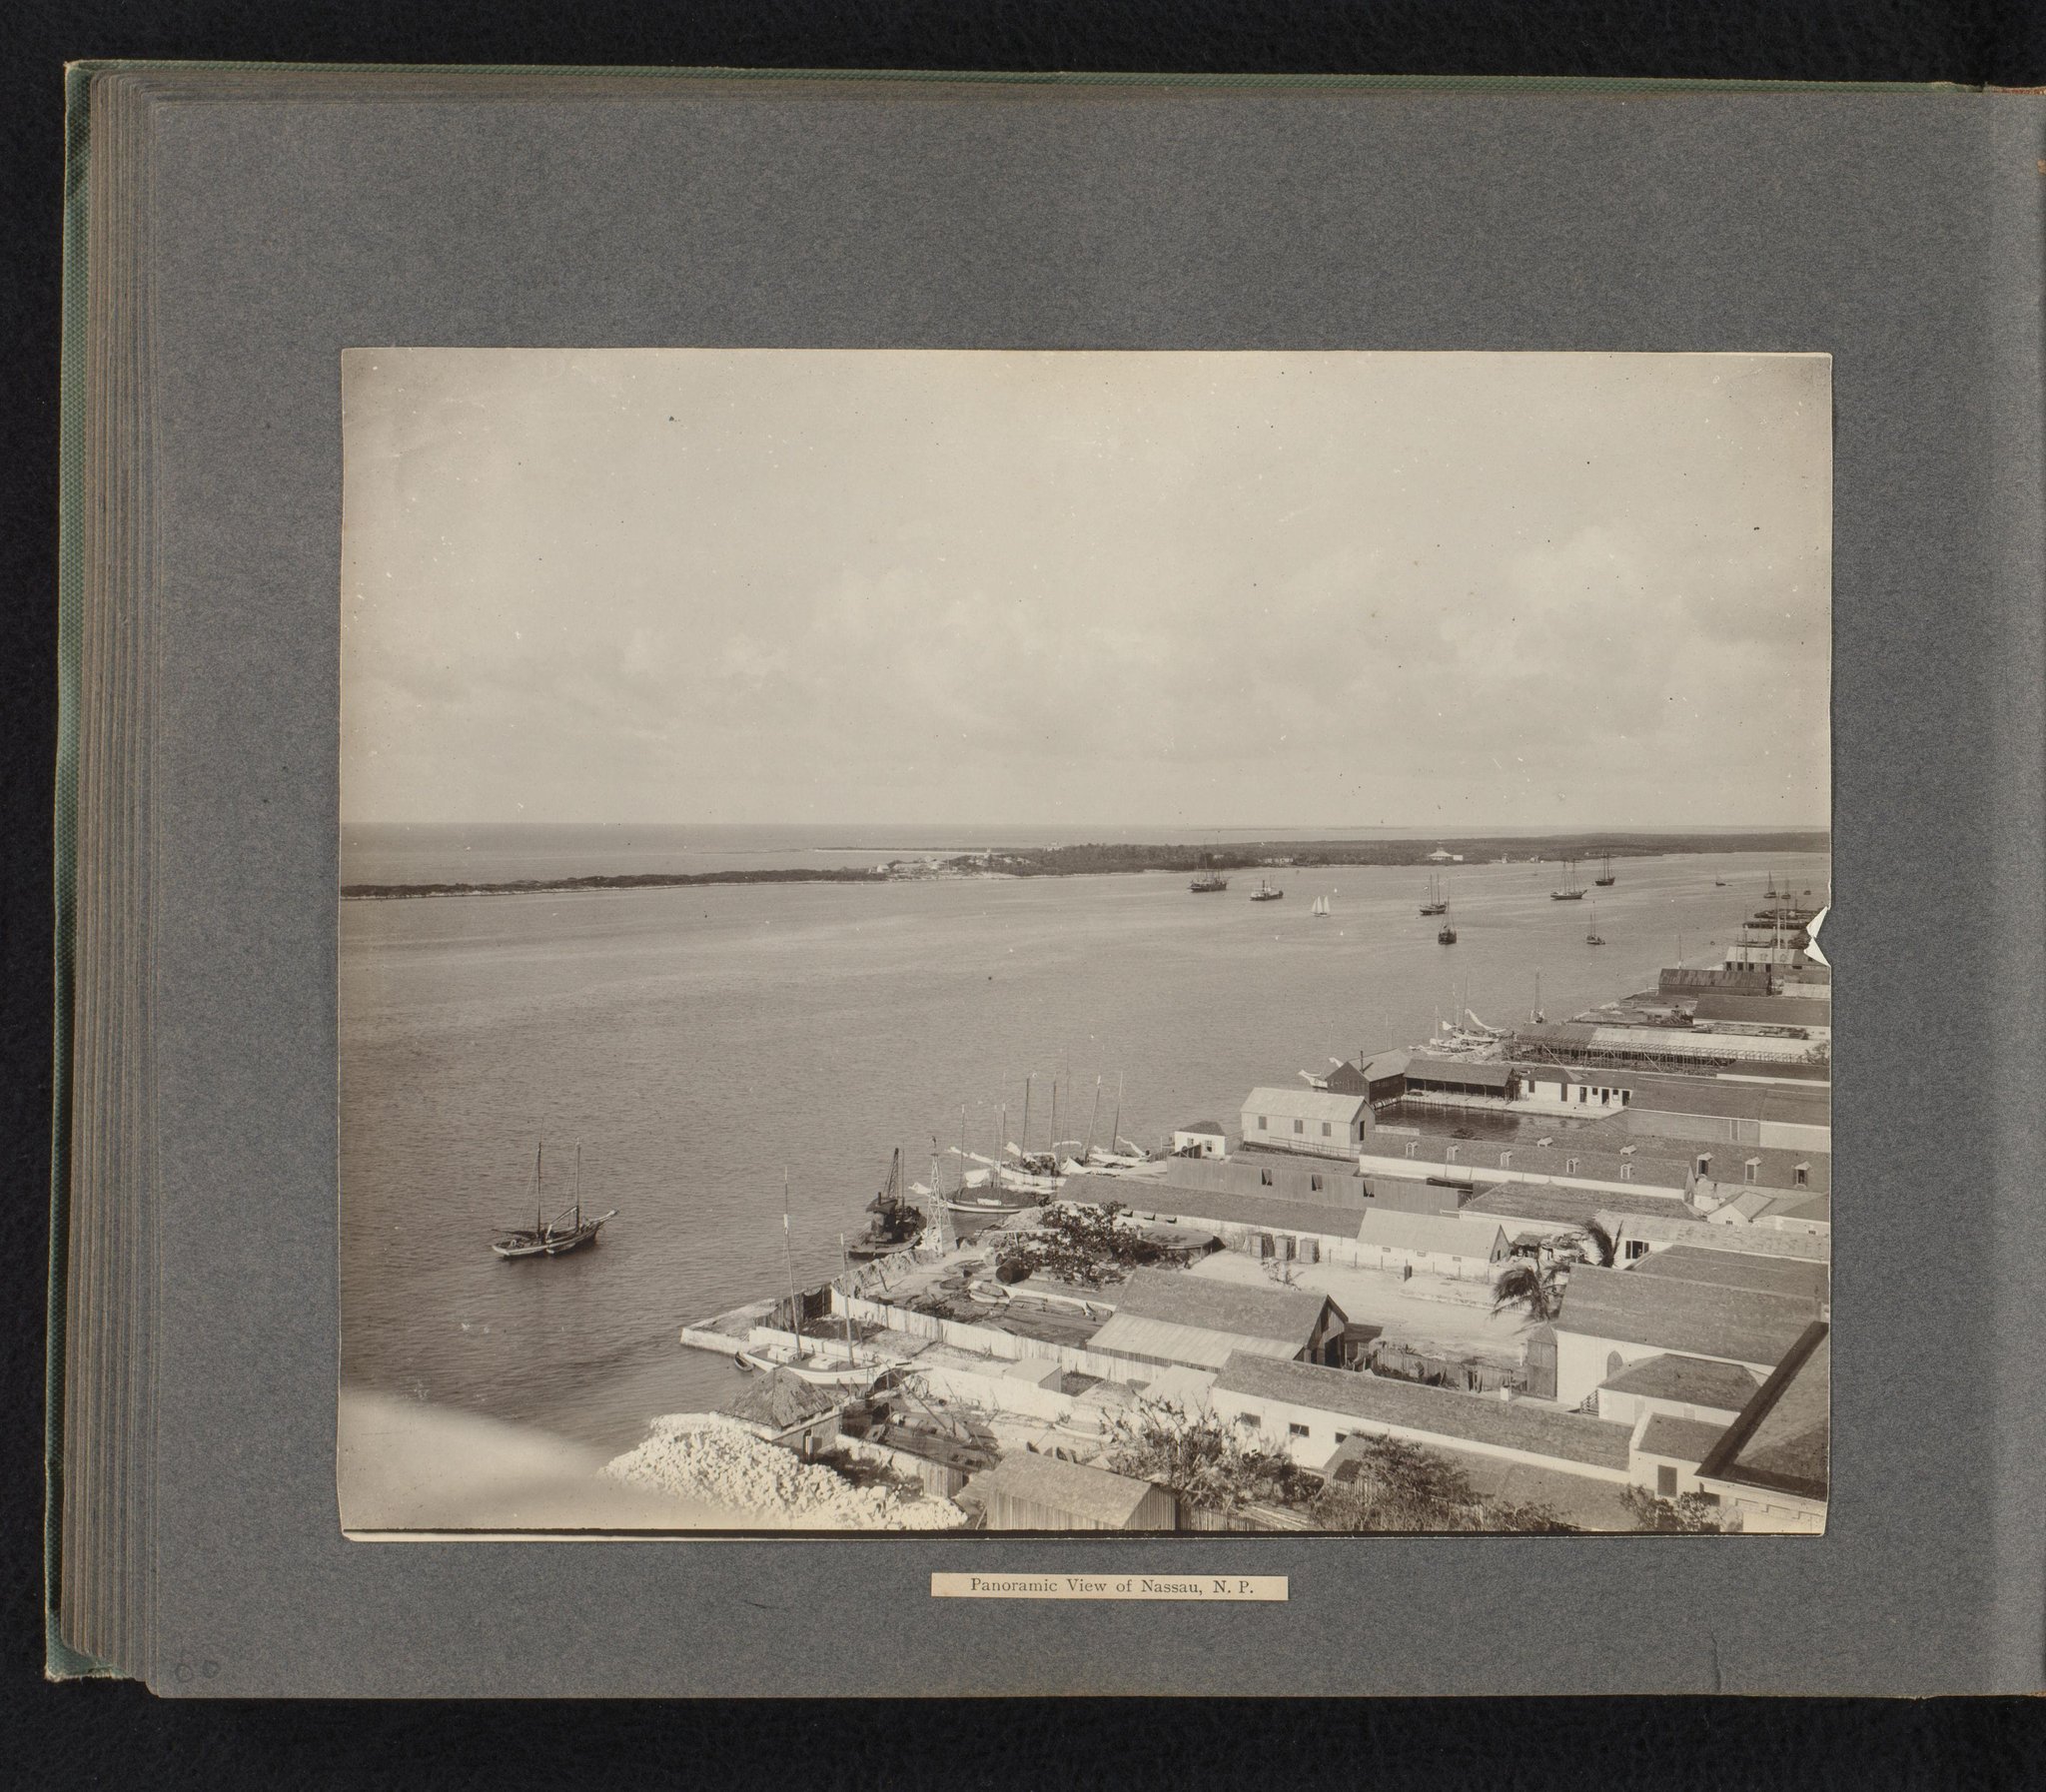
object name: photograph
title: Gezicht over de Atlantische Oceaan vanuit Nassau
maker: jacob frank coonley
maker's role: fotograaf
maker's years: 1832-1915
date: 1889-1895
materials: paper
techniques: platinum process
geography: nassau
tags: gulf, bay, city-view in general; 'veduta', ships (in general), atlantic ocean